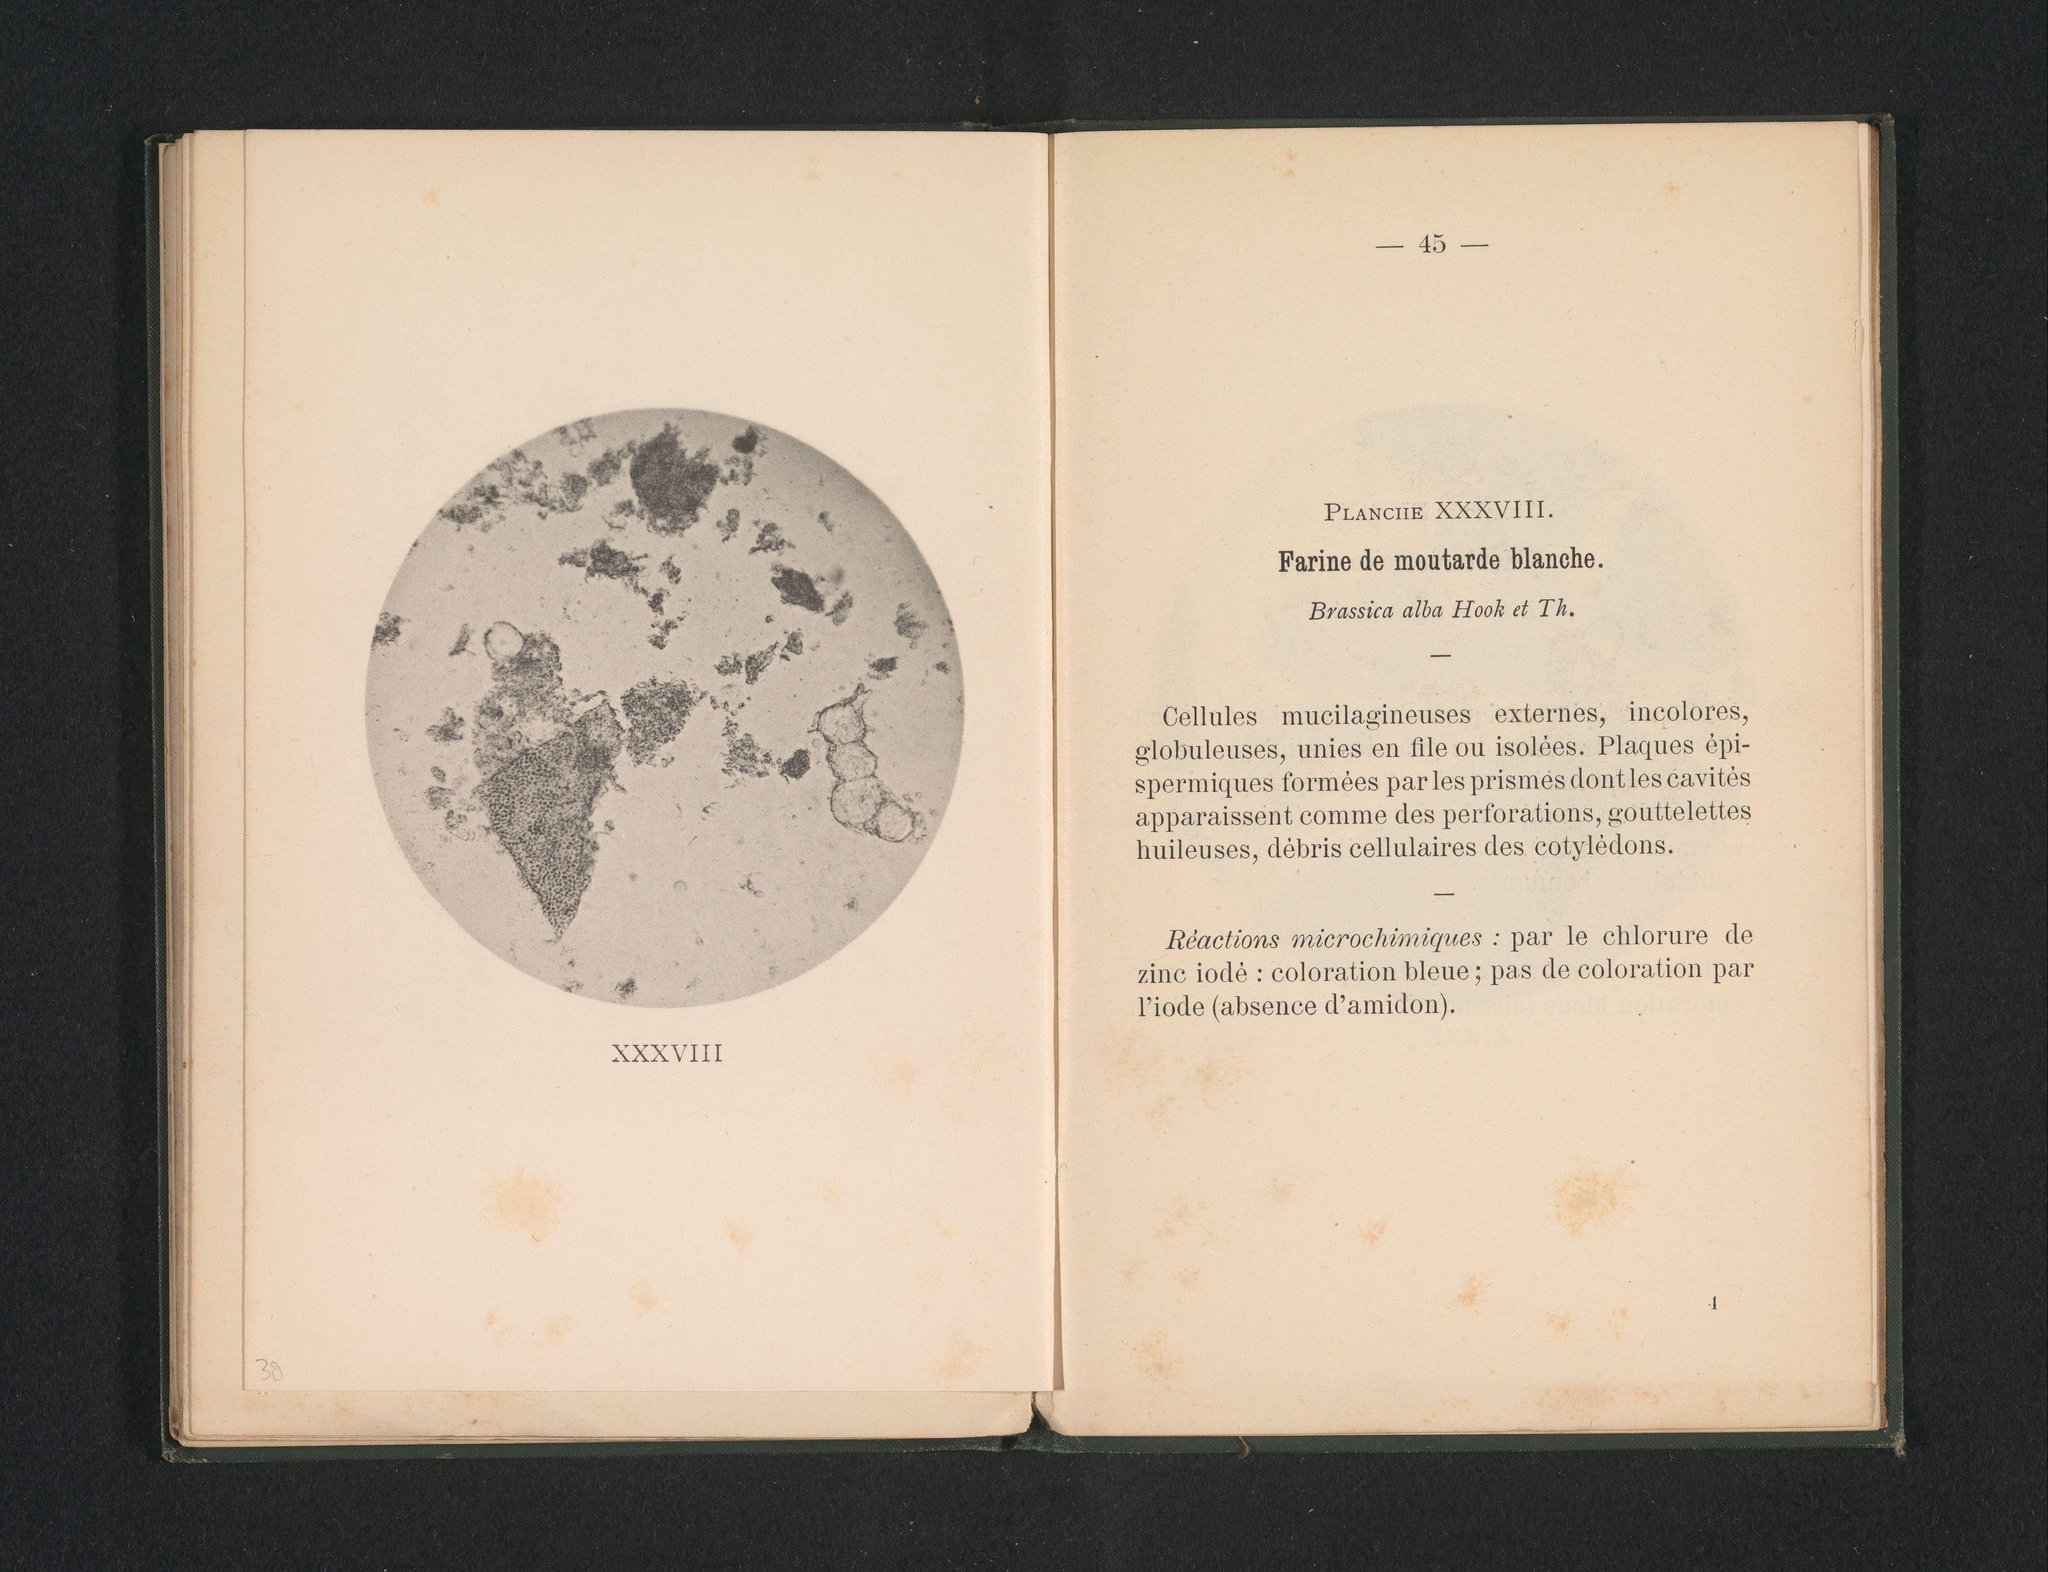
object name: photomechanical print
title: Microscopische weergave van witte mosterdmeel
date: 1891-1896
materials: paper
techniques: photograph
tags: microscope (+ scientific research)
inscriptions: number: ‘XXXVIII’